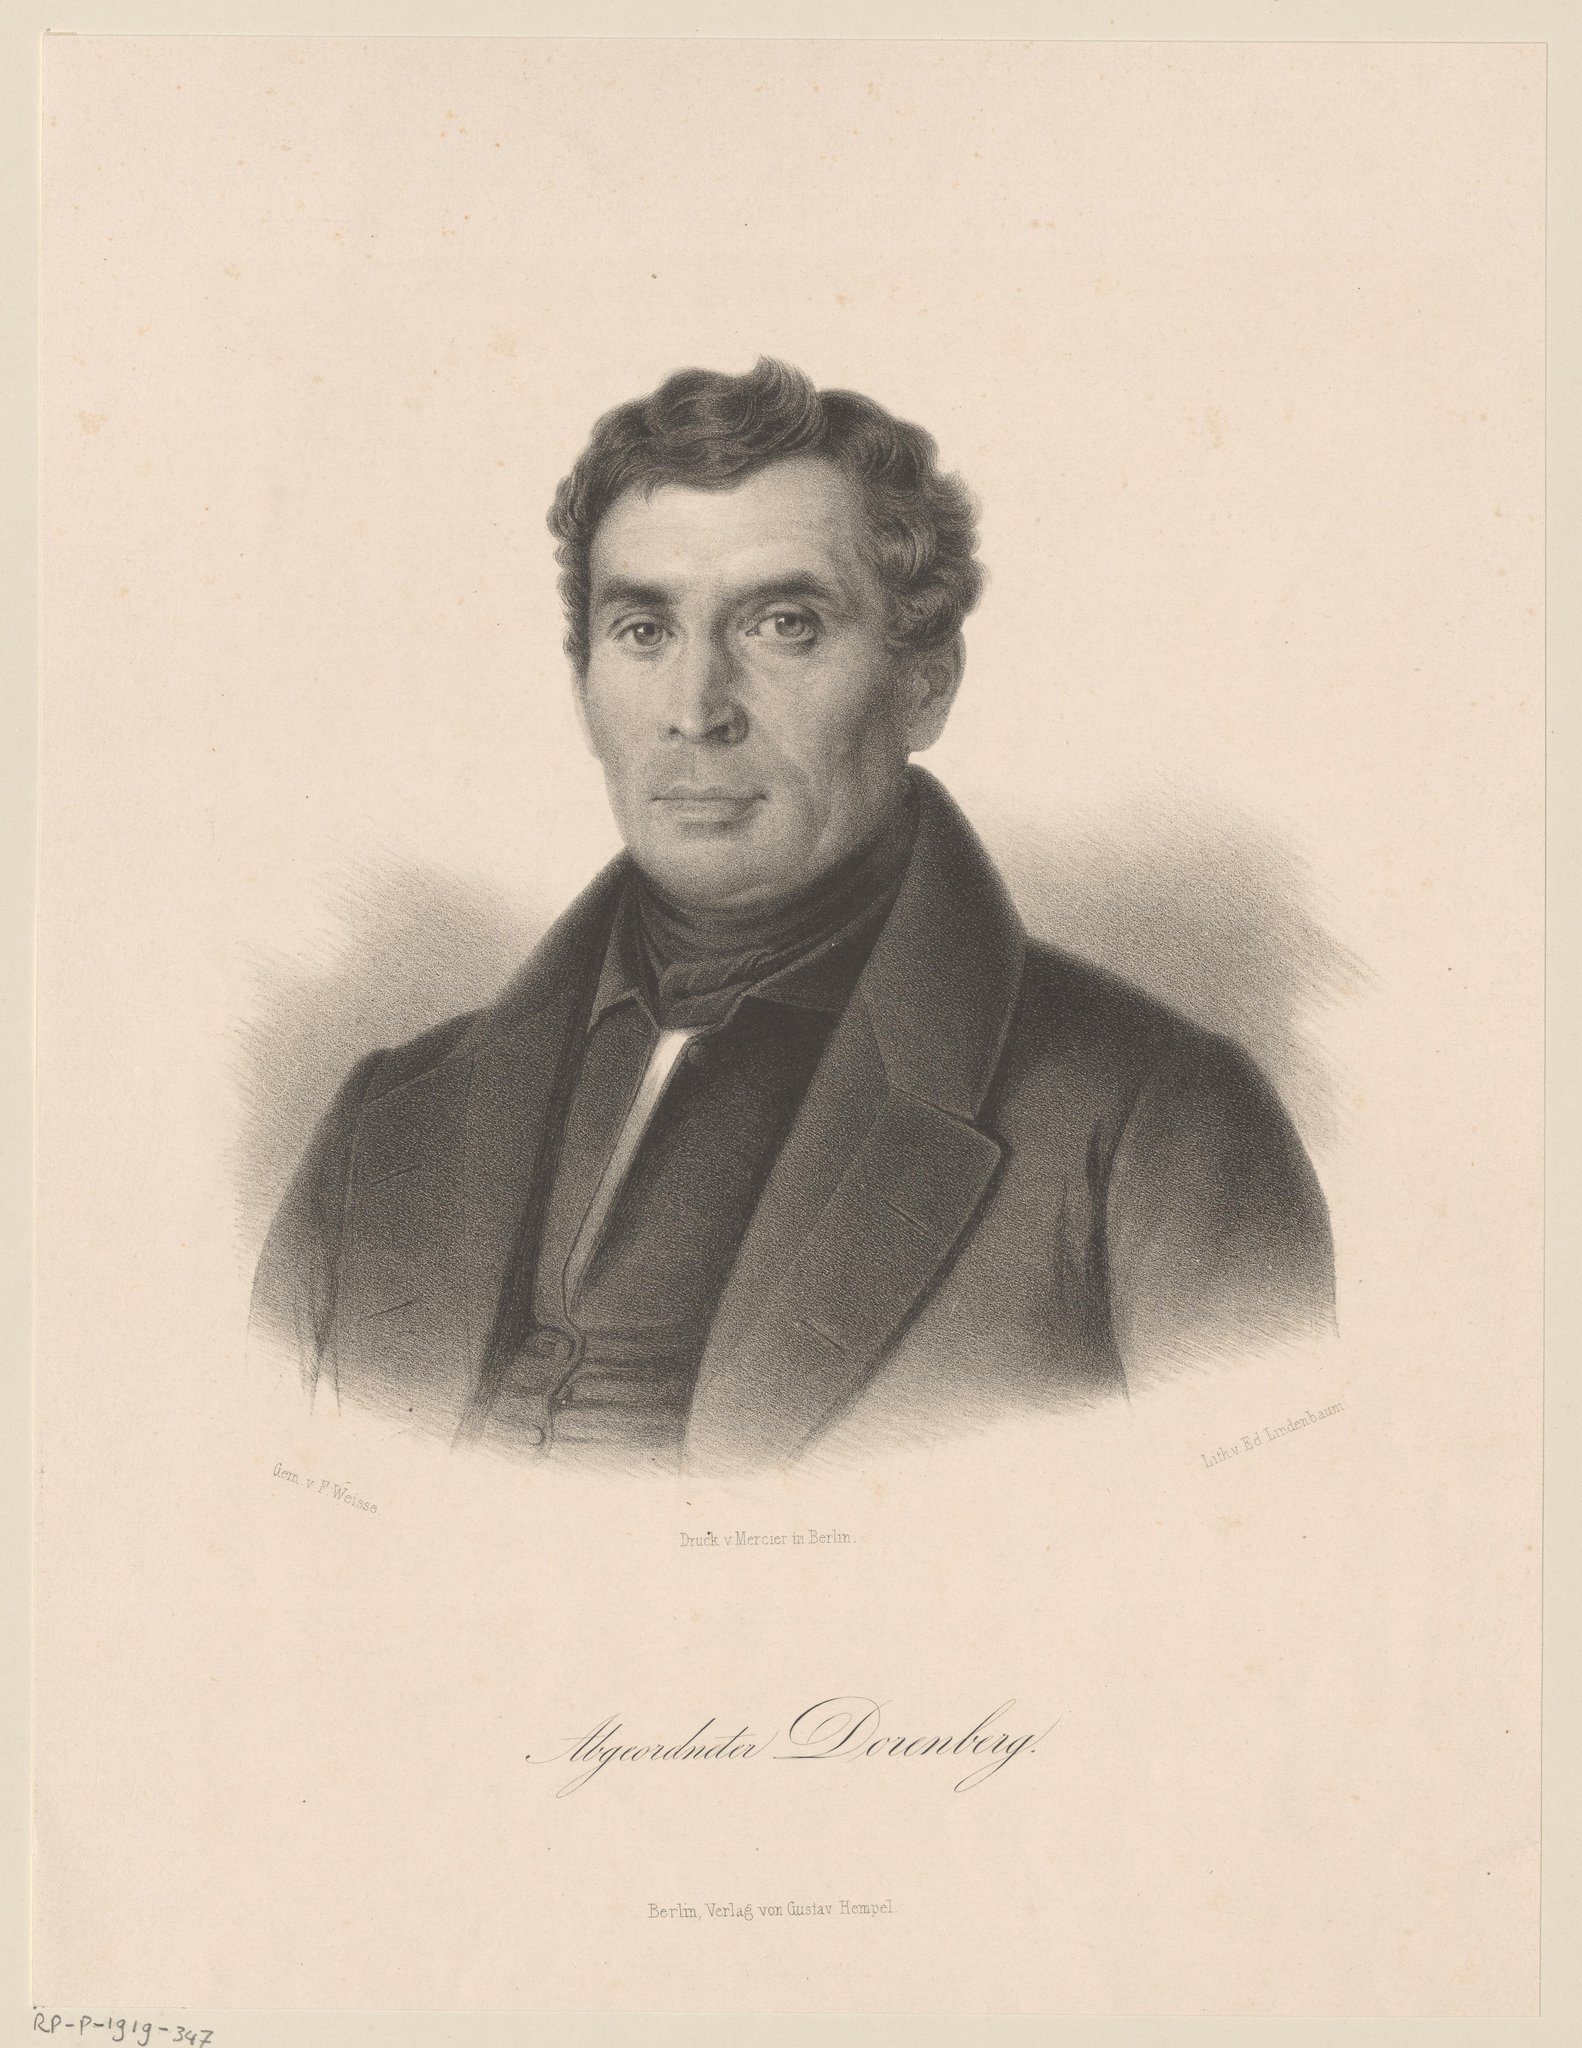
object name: print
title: Portret van parlementslid Dorenberg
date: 1846-1877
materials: paper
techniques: lithograph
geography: berlin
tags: politician, historical persons